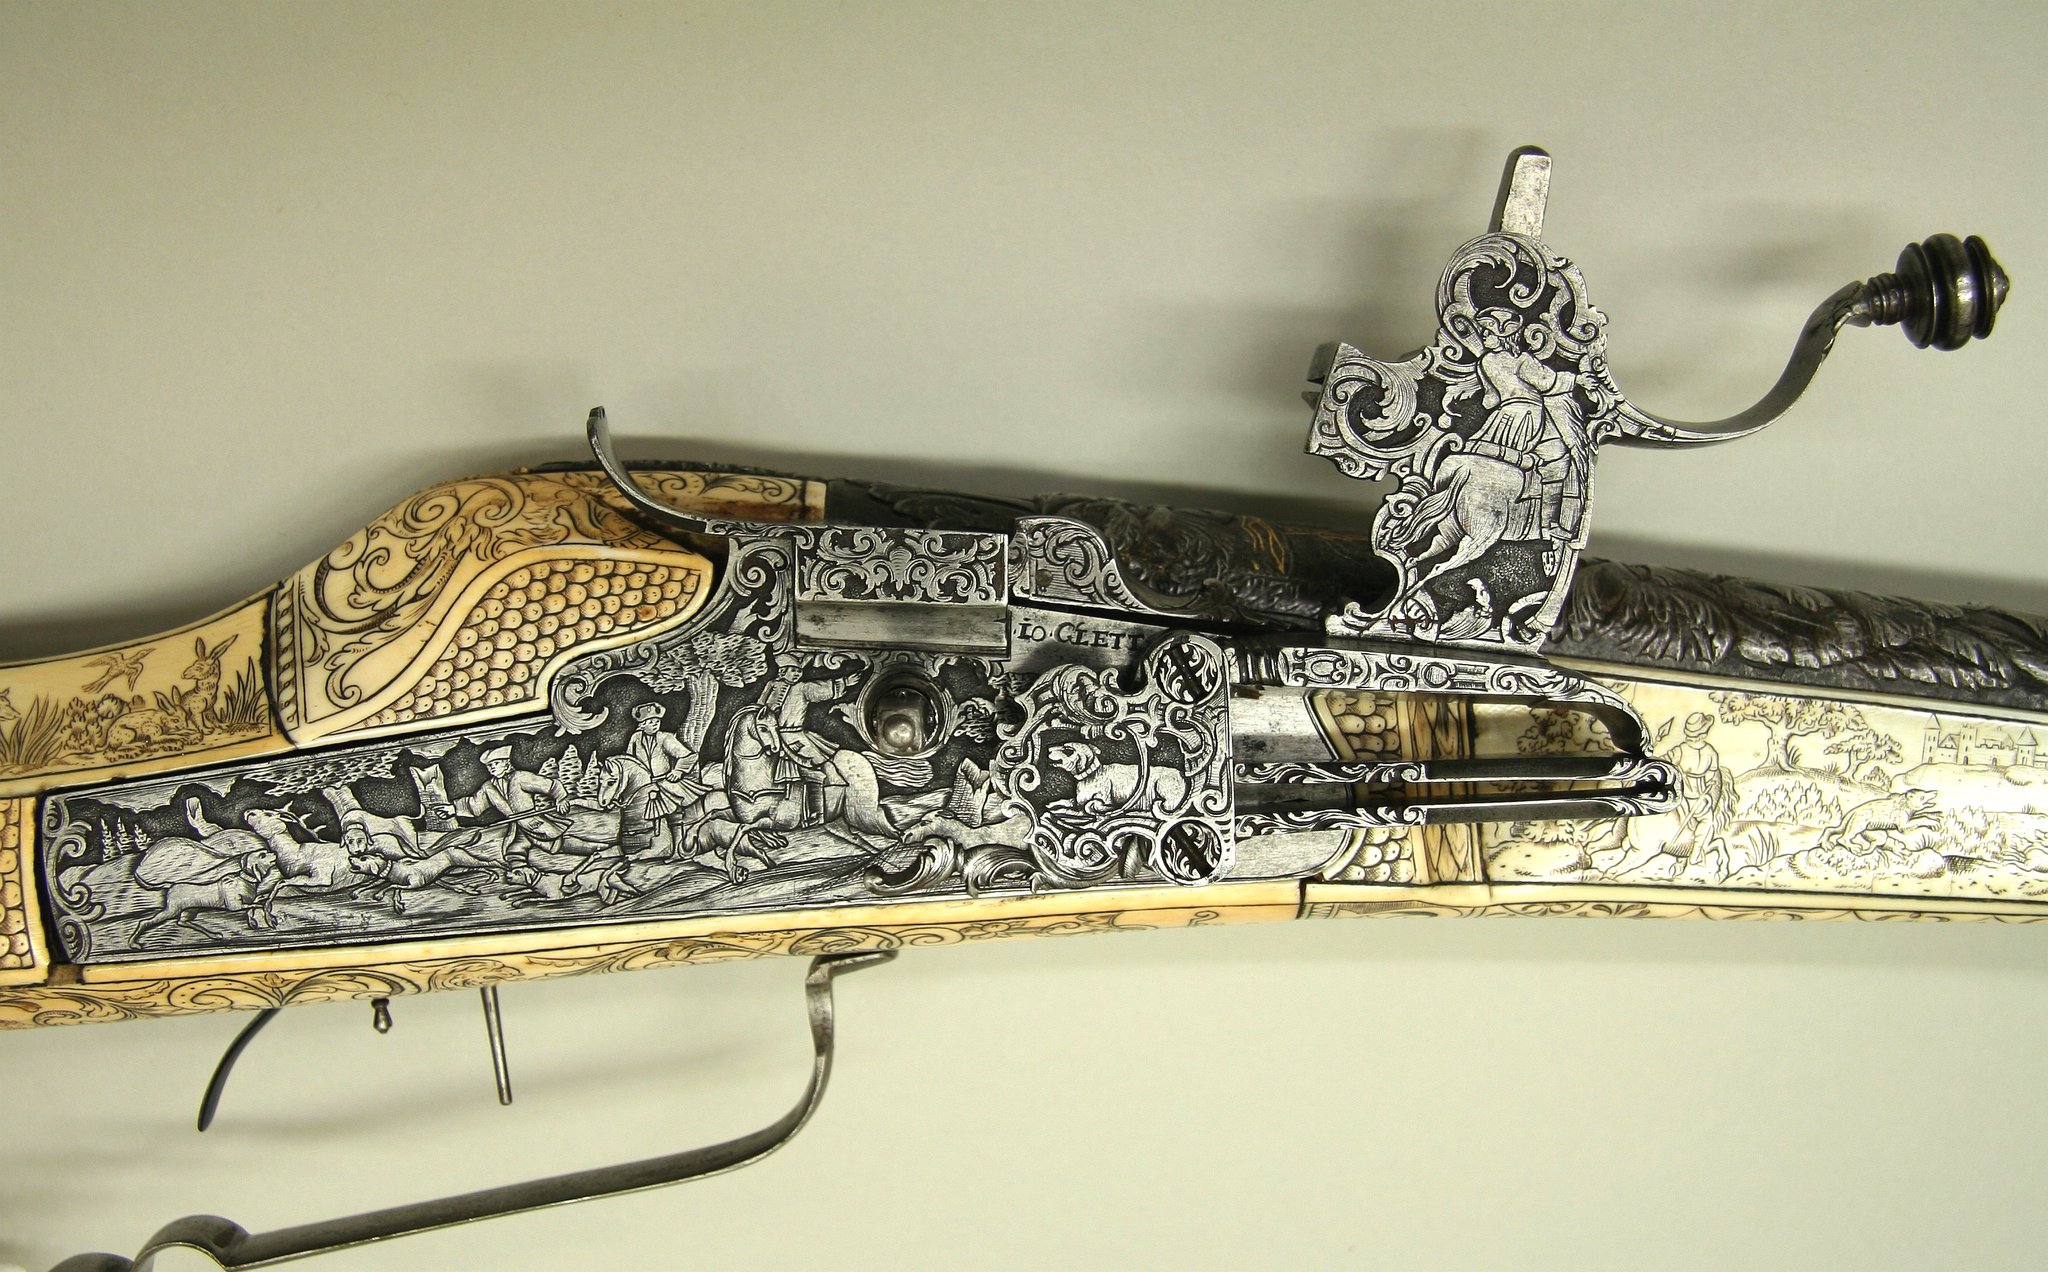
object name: wheellock gun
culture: german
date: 1601-1700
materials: gold, ivory, silver, steel, wood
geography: germany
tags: men,hunting,dogs,horses